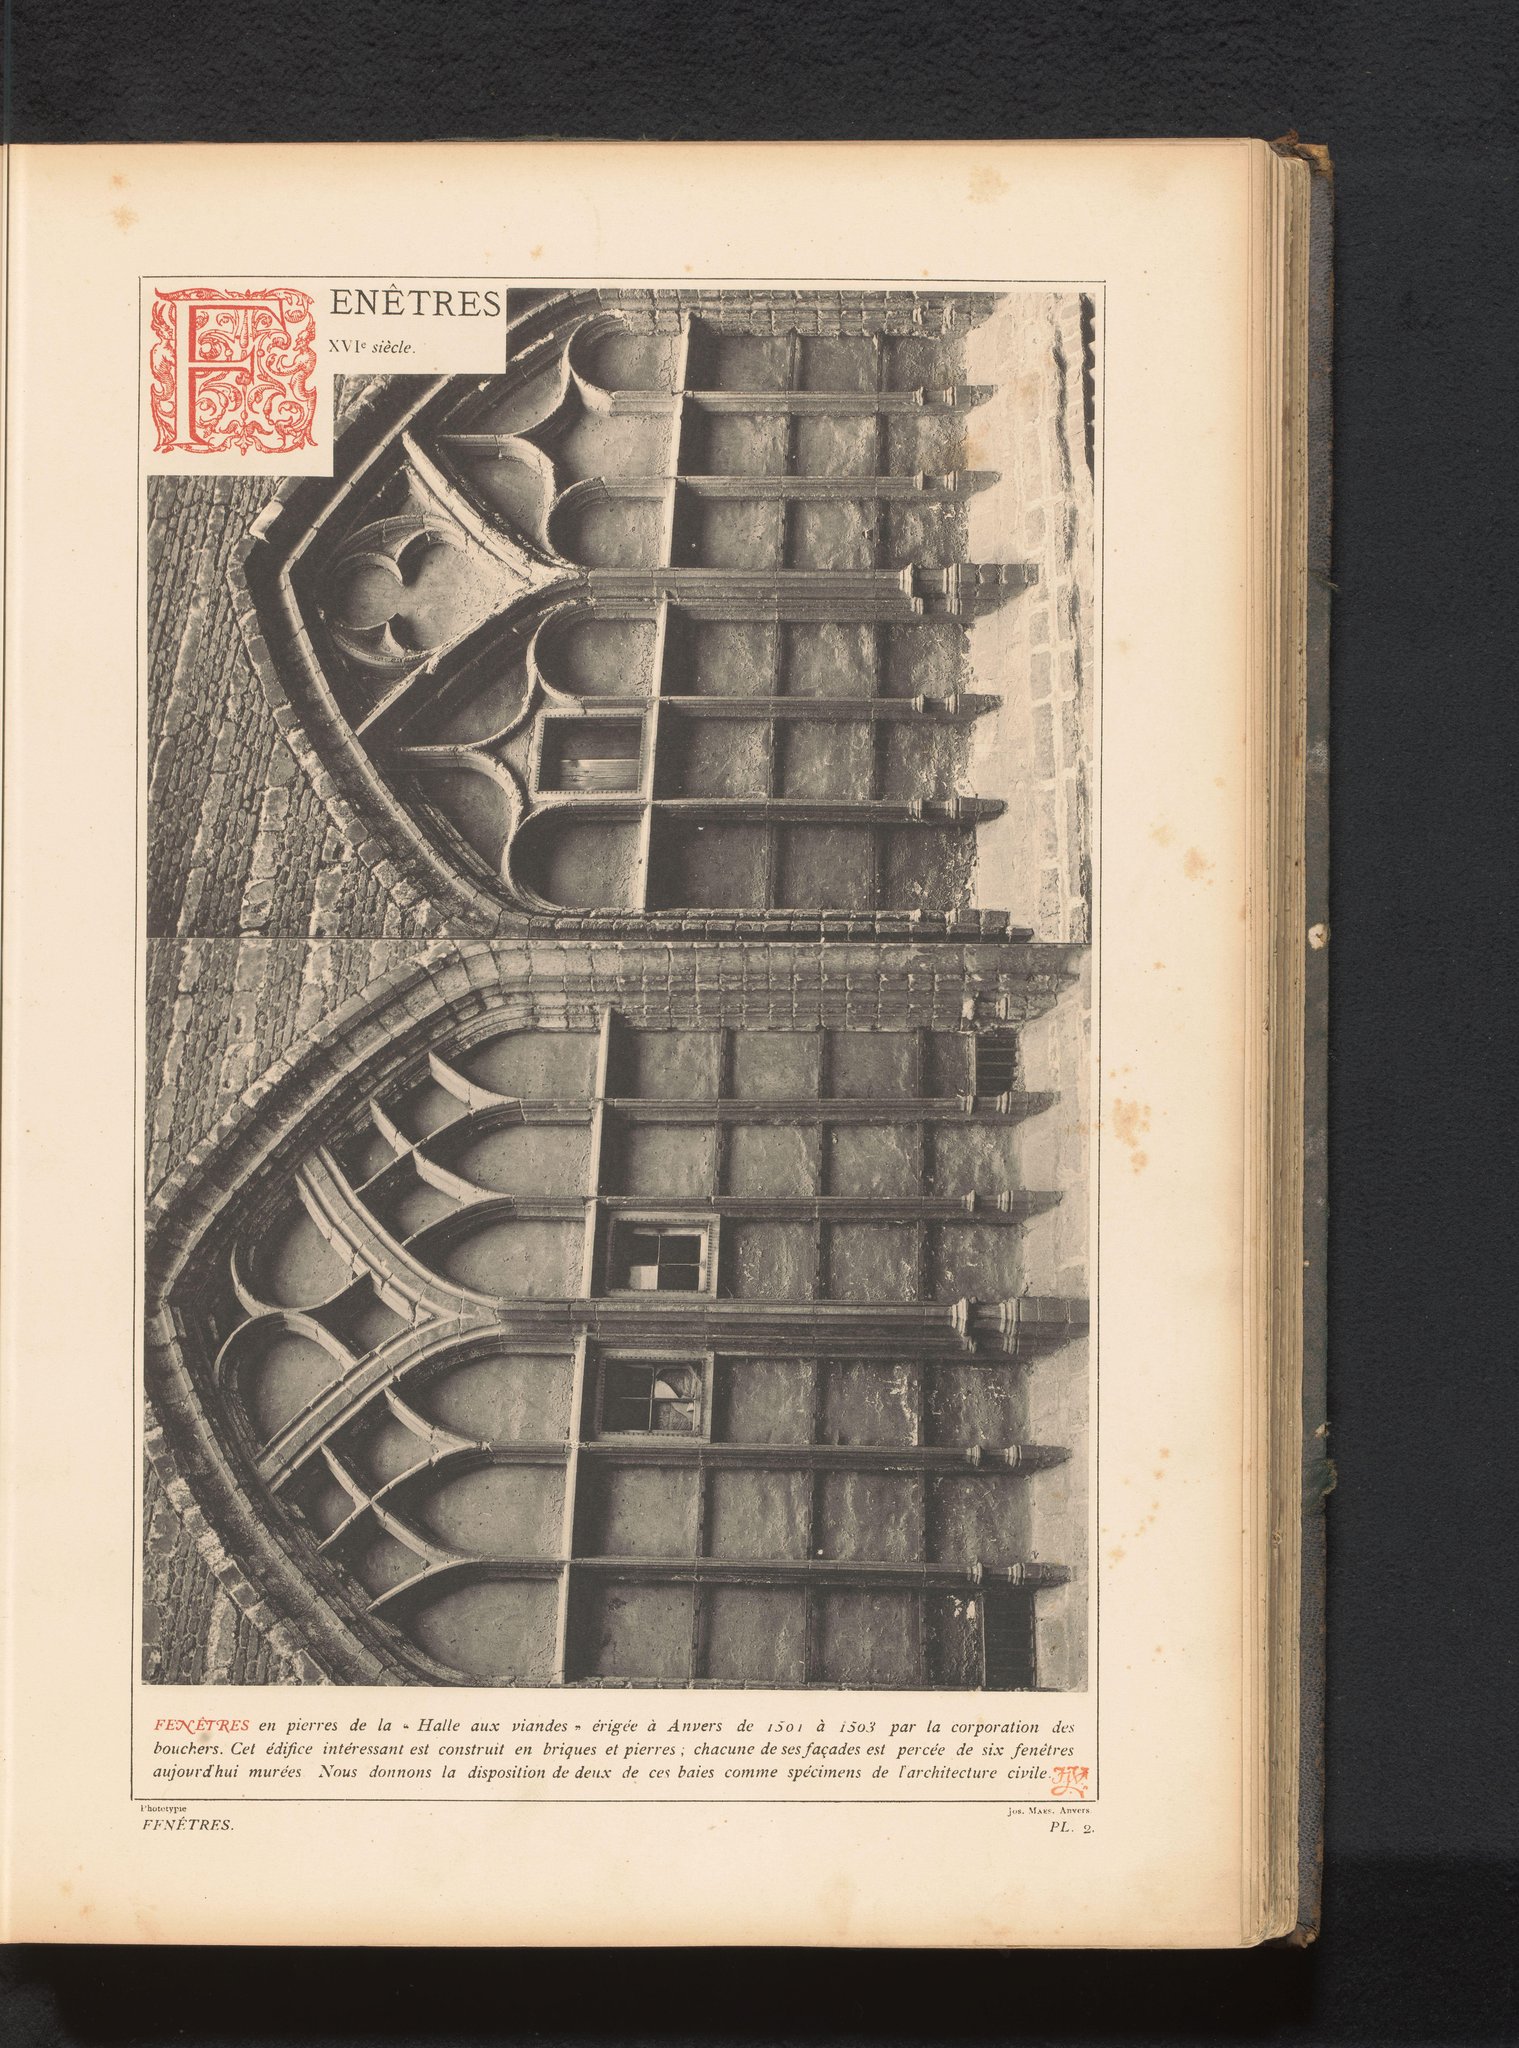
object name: photomechanical print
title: Fenêtres, XVIe siècle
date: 1882-1887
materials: paper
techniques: photograph, photolithography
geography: antwerp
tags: window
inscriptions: monogram: ‘JJvY’, inscription: ‘FENÊTRES en pierres (...)’, inscription: ‘FENÊTRES. - PL. 2.’